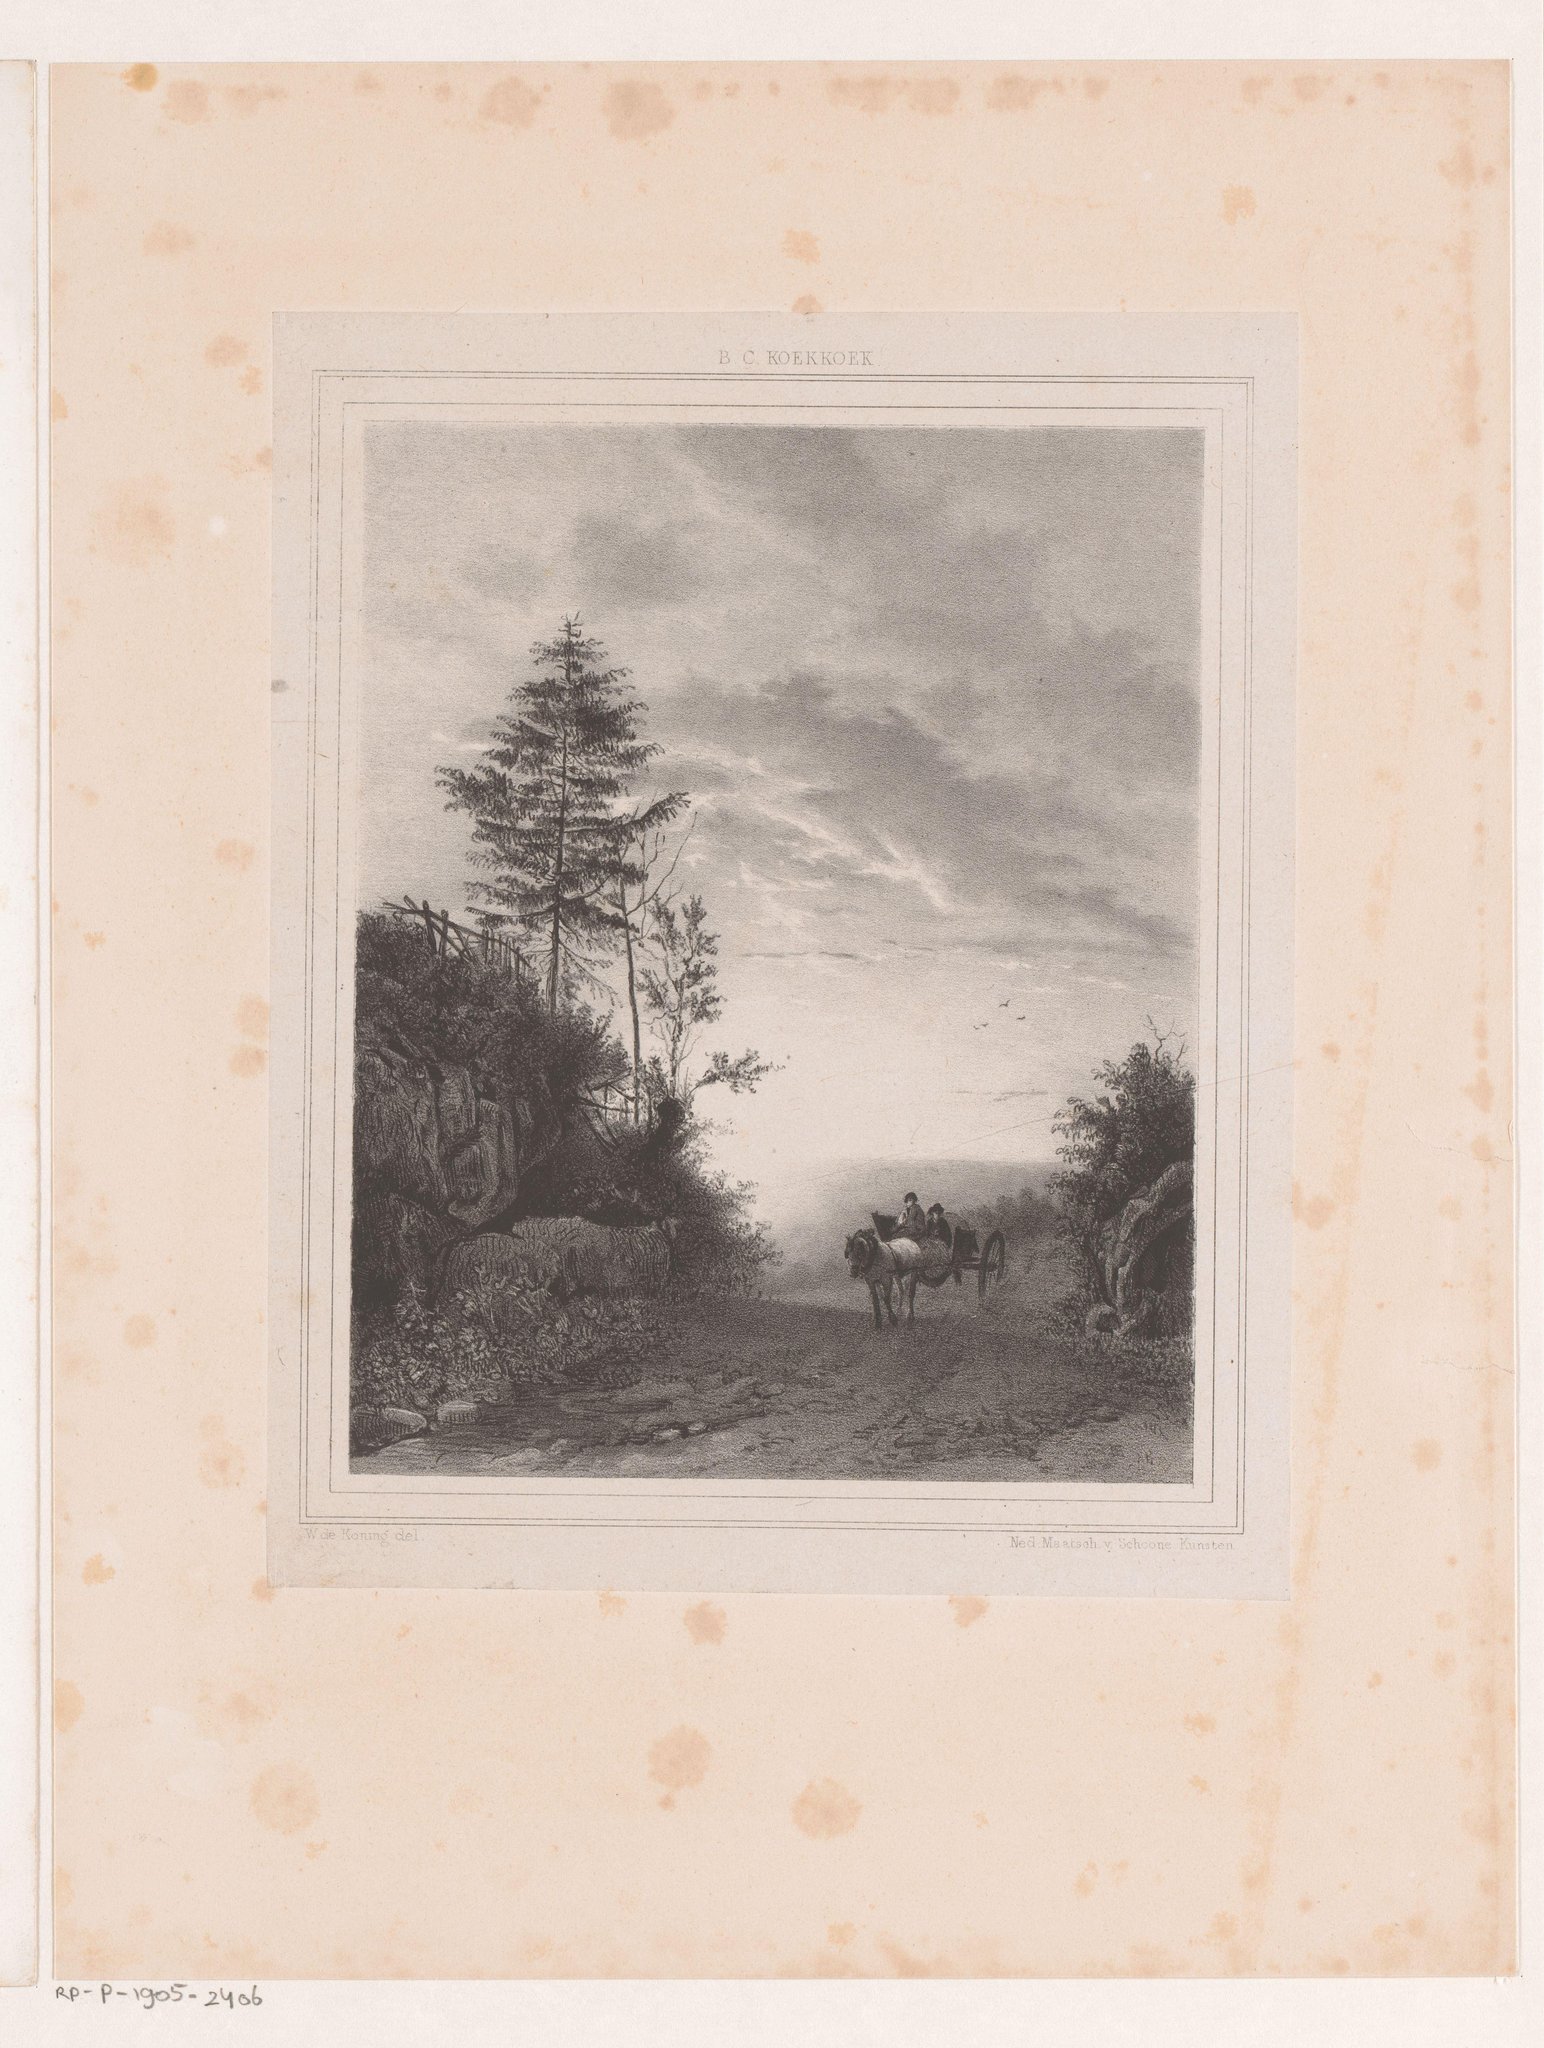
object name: print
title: Landweg met paard en wagen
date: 1840-1843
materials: paper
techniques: lithograph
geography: the hague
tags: forest of coniferous trees, two-wheeled vehicle drawn by one animal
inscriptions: collector's mark: Lugt 2228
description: In de wagen zitten twee figuren. Links naast de weg staat een naaldboom.